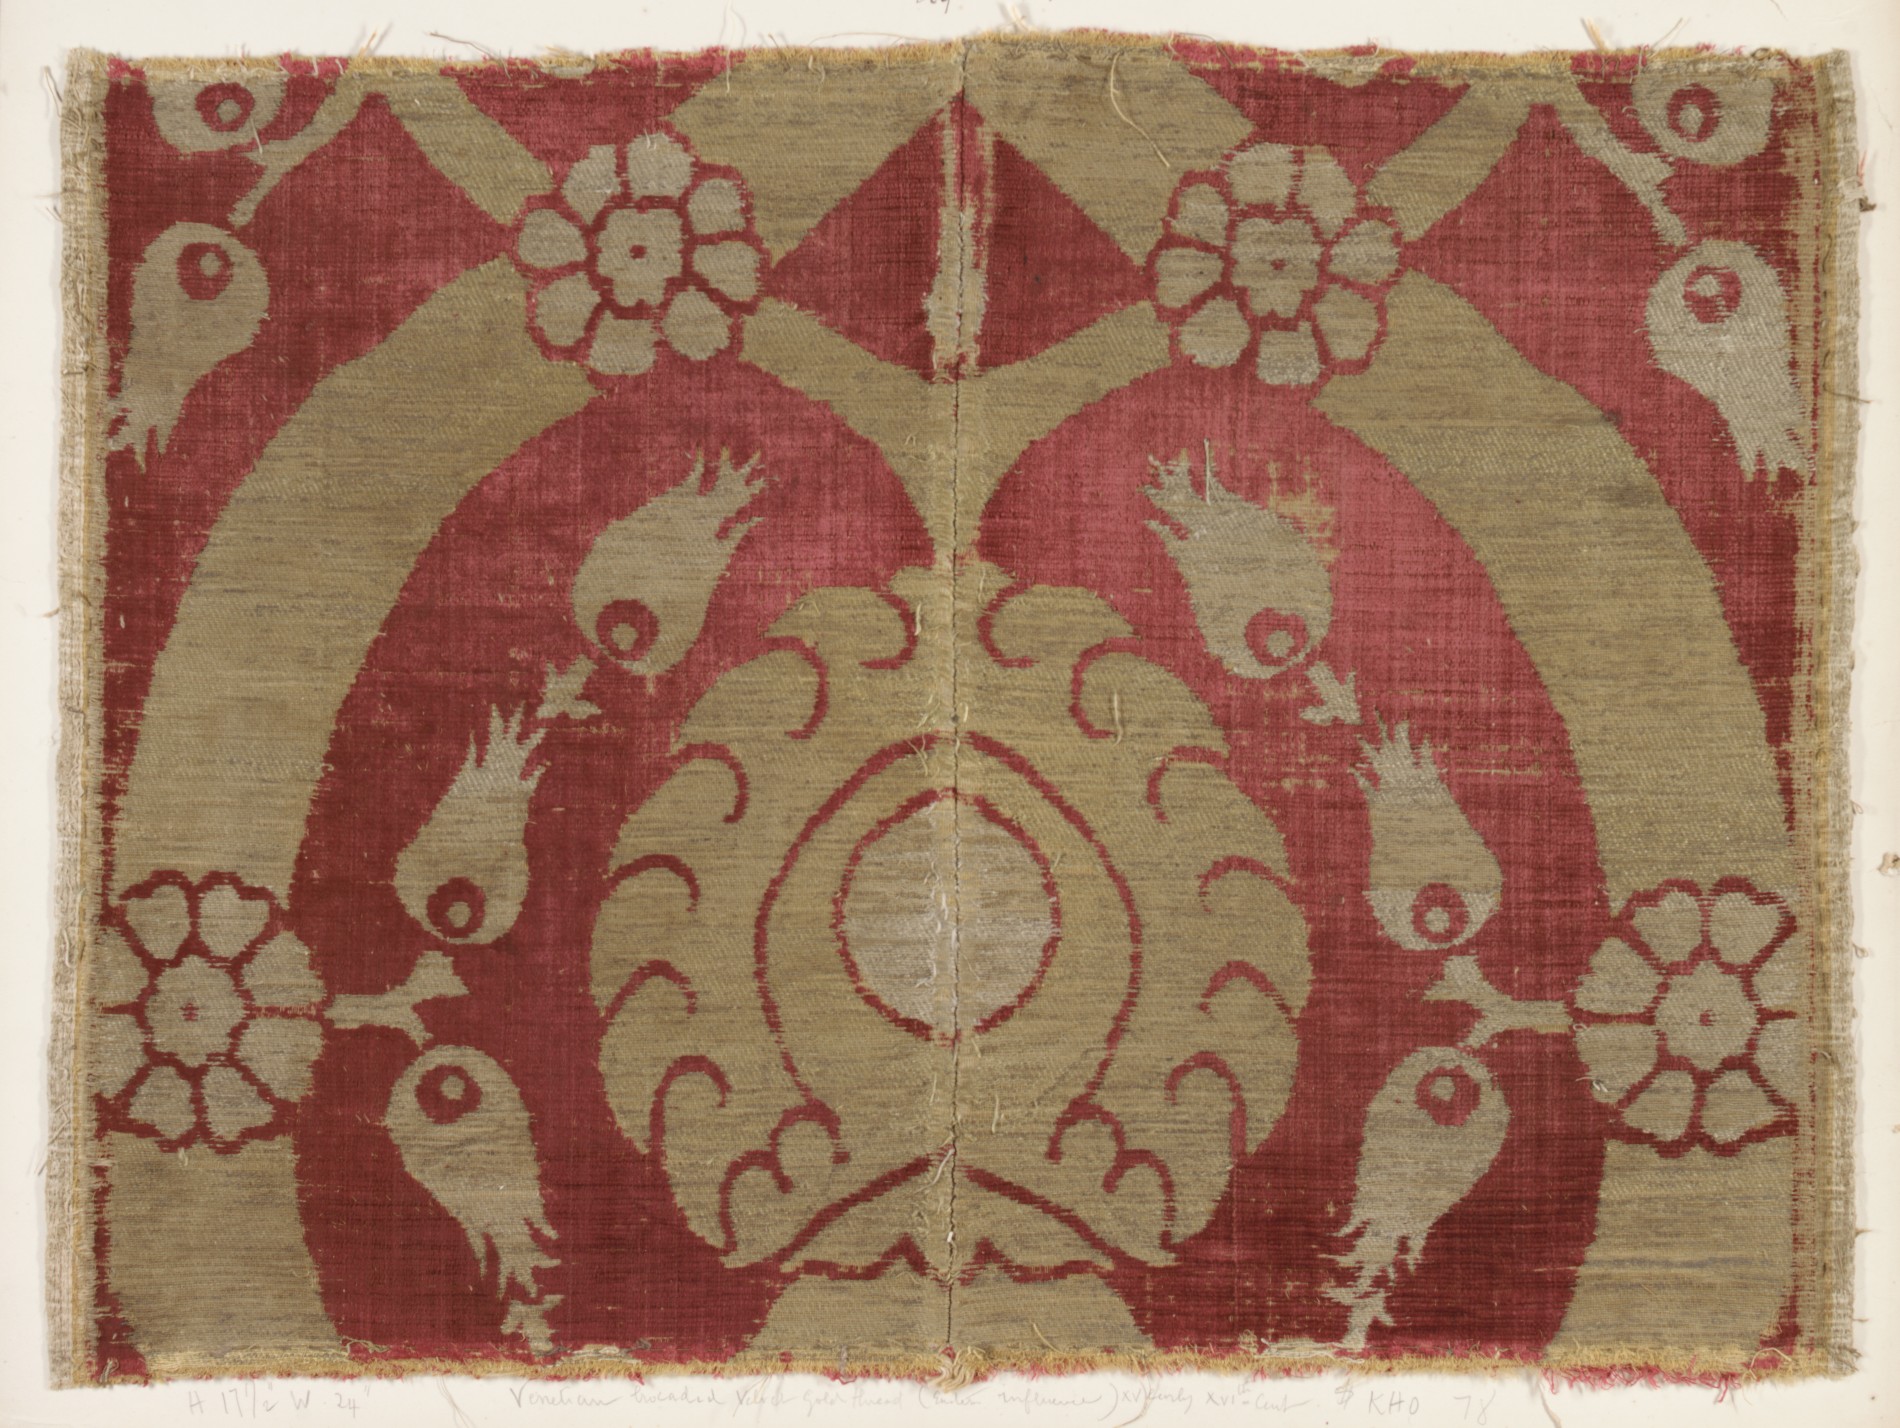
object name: fragment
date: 1401-1533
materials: metal thread, silk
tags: flowers